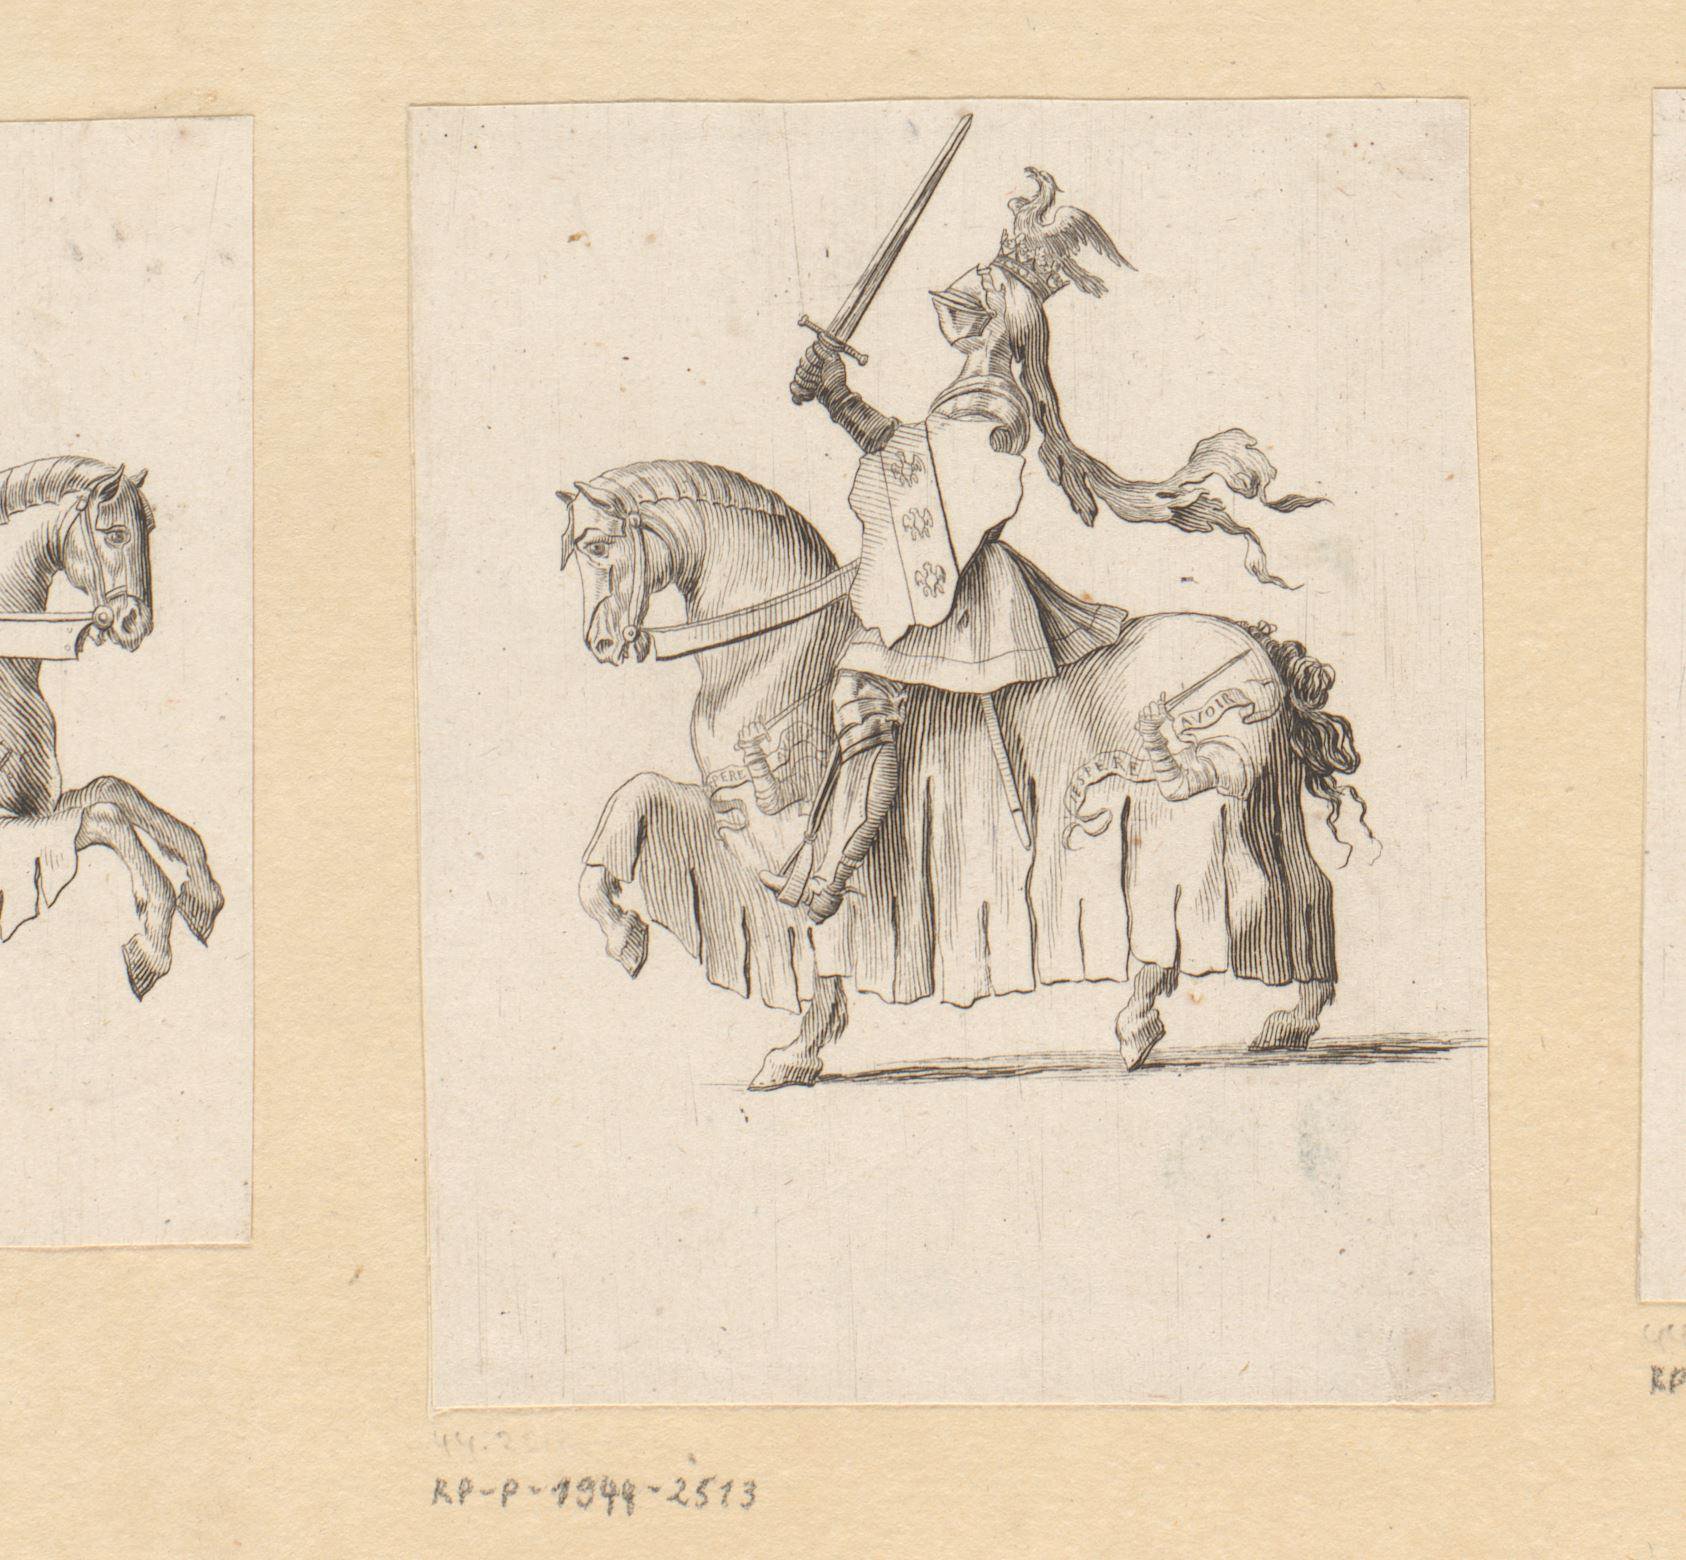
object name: print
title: Ridders te paard in verschillende houdingen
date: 1647-1714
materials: paper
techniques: engraving, etching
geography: france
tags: riding a horse, ass, or mule; rider, horseman, armour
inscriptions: collector's mark: Lugt 240